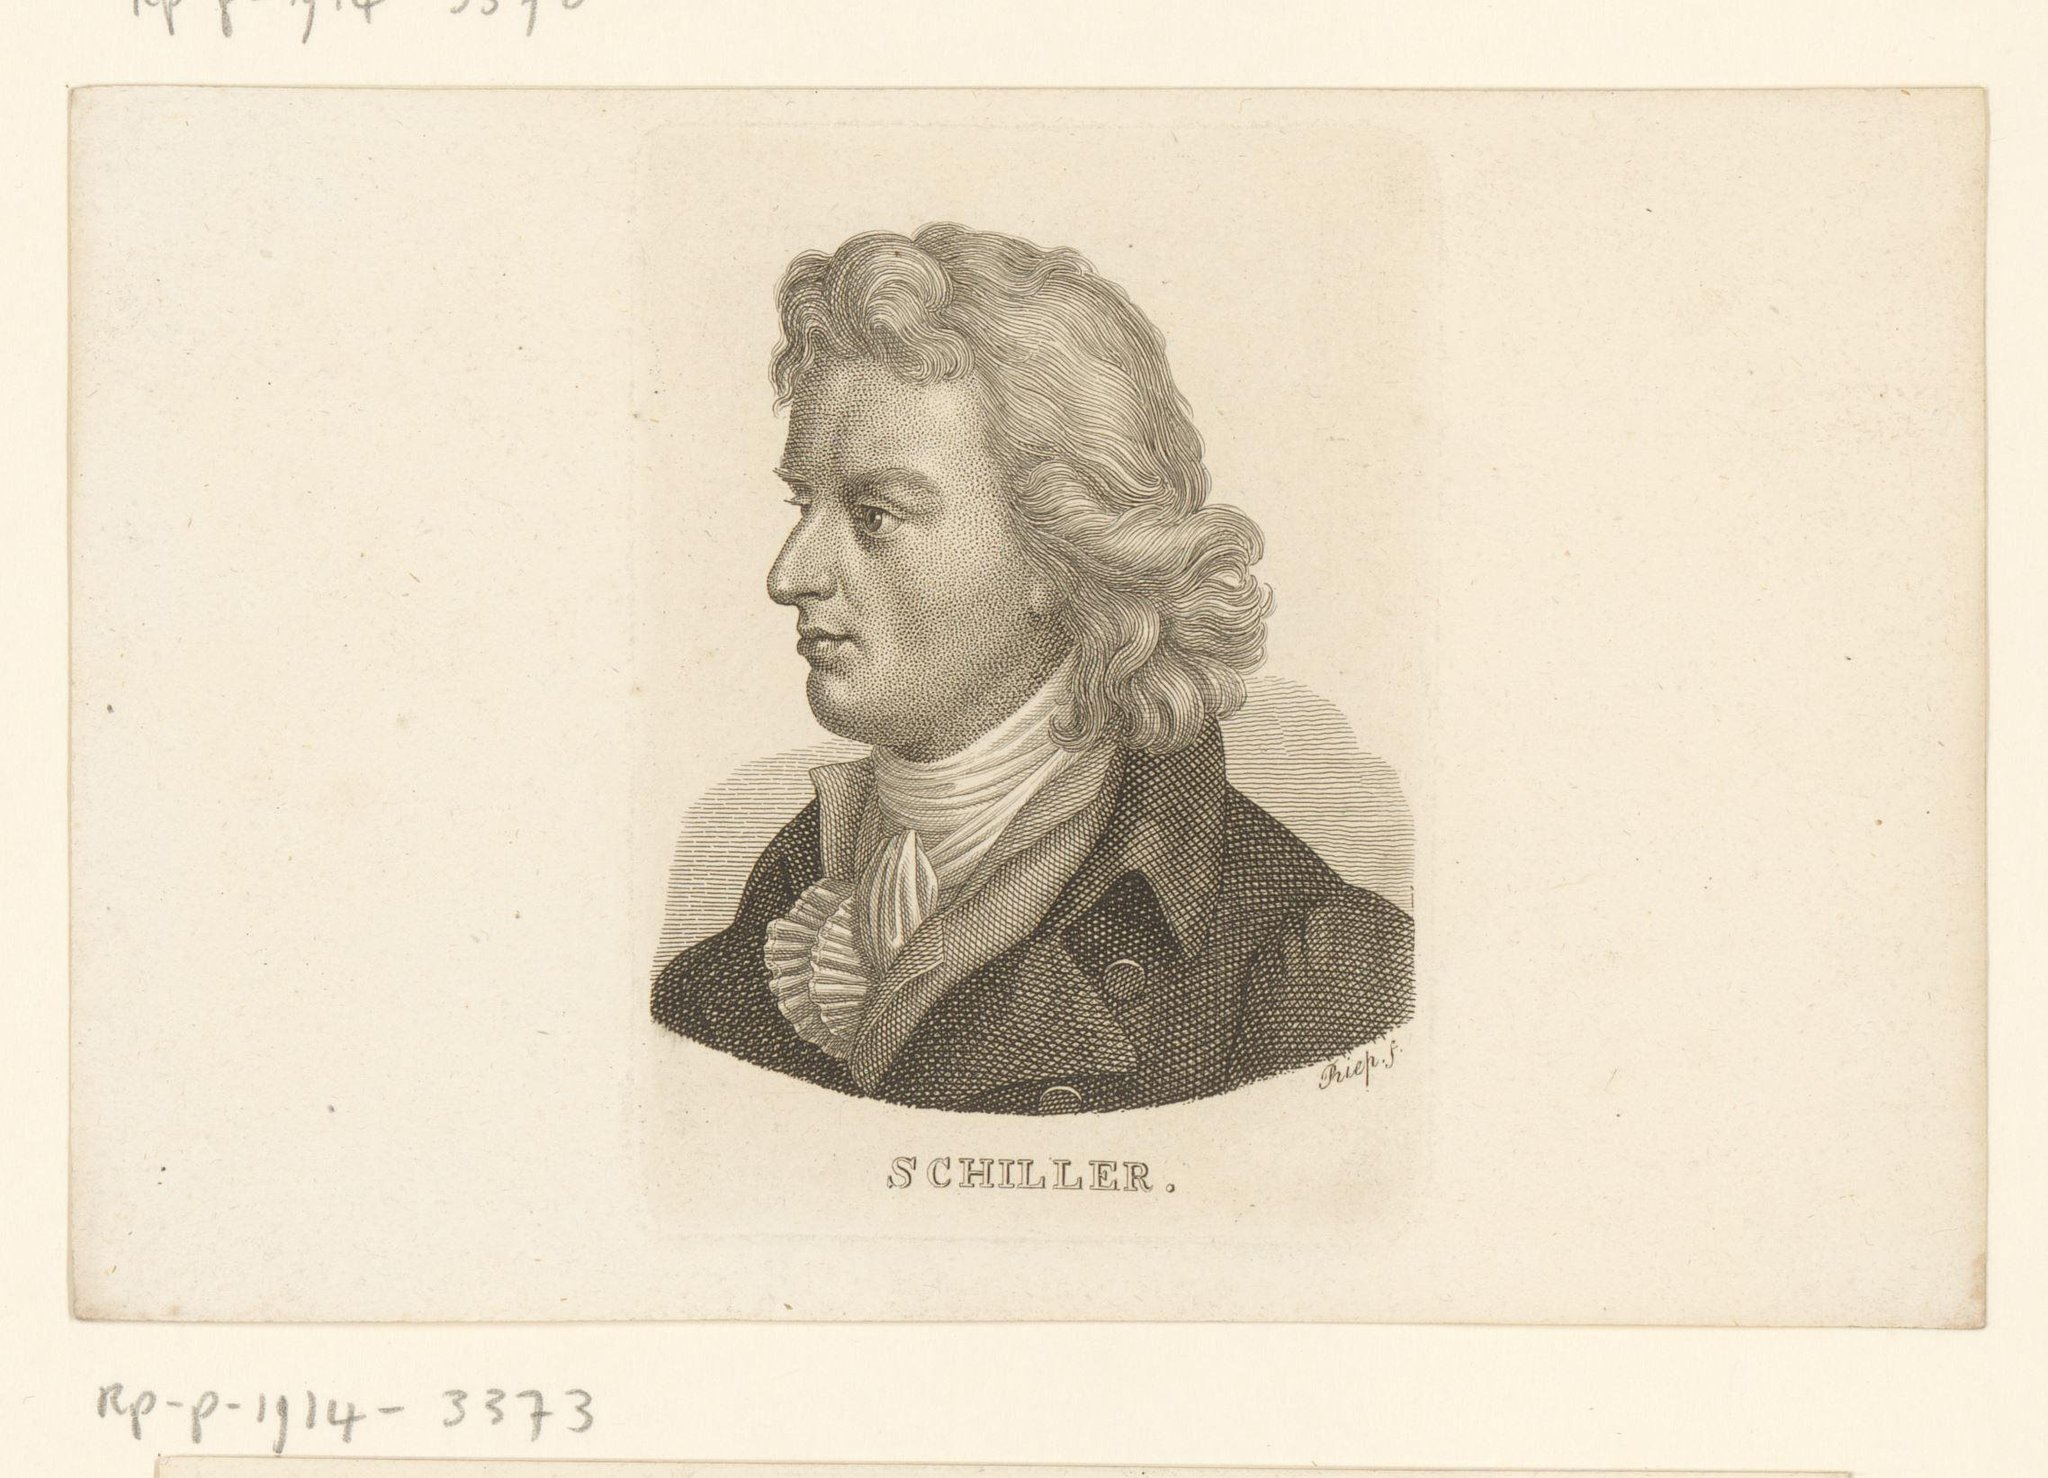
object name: print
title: Portret van Friedrich von Schiller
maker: ernst ludwig riepenhausen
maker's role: print maker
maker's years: 1765-1840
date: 1775-1840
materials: paper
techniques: engraving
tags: friedrich von schiller, historical persons, writer, poet, author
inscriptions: collector's mark: Lugt 2228